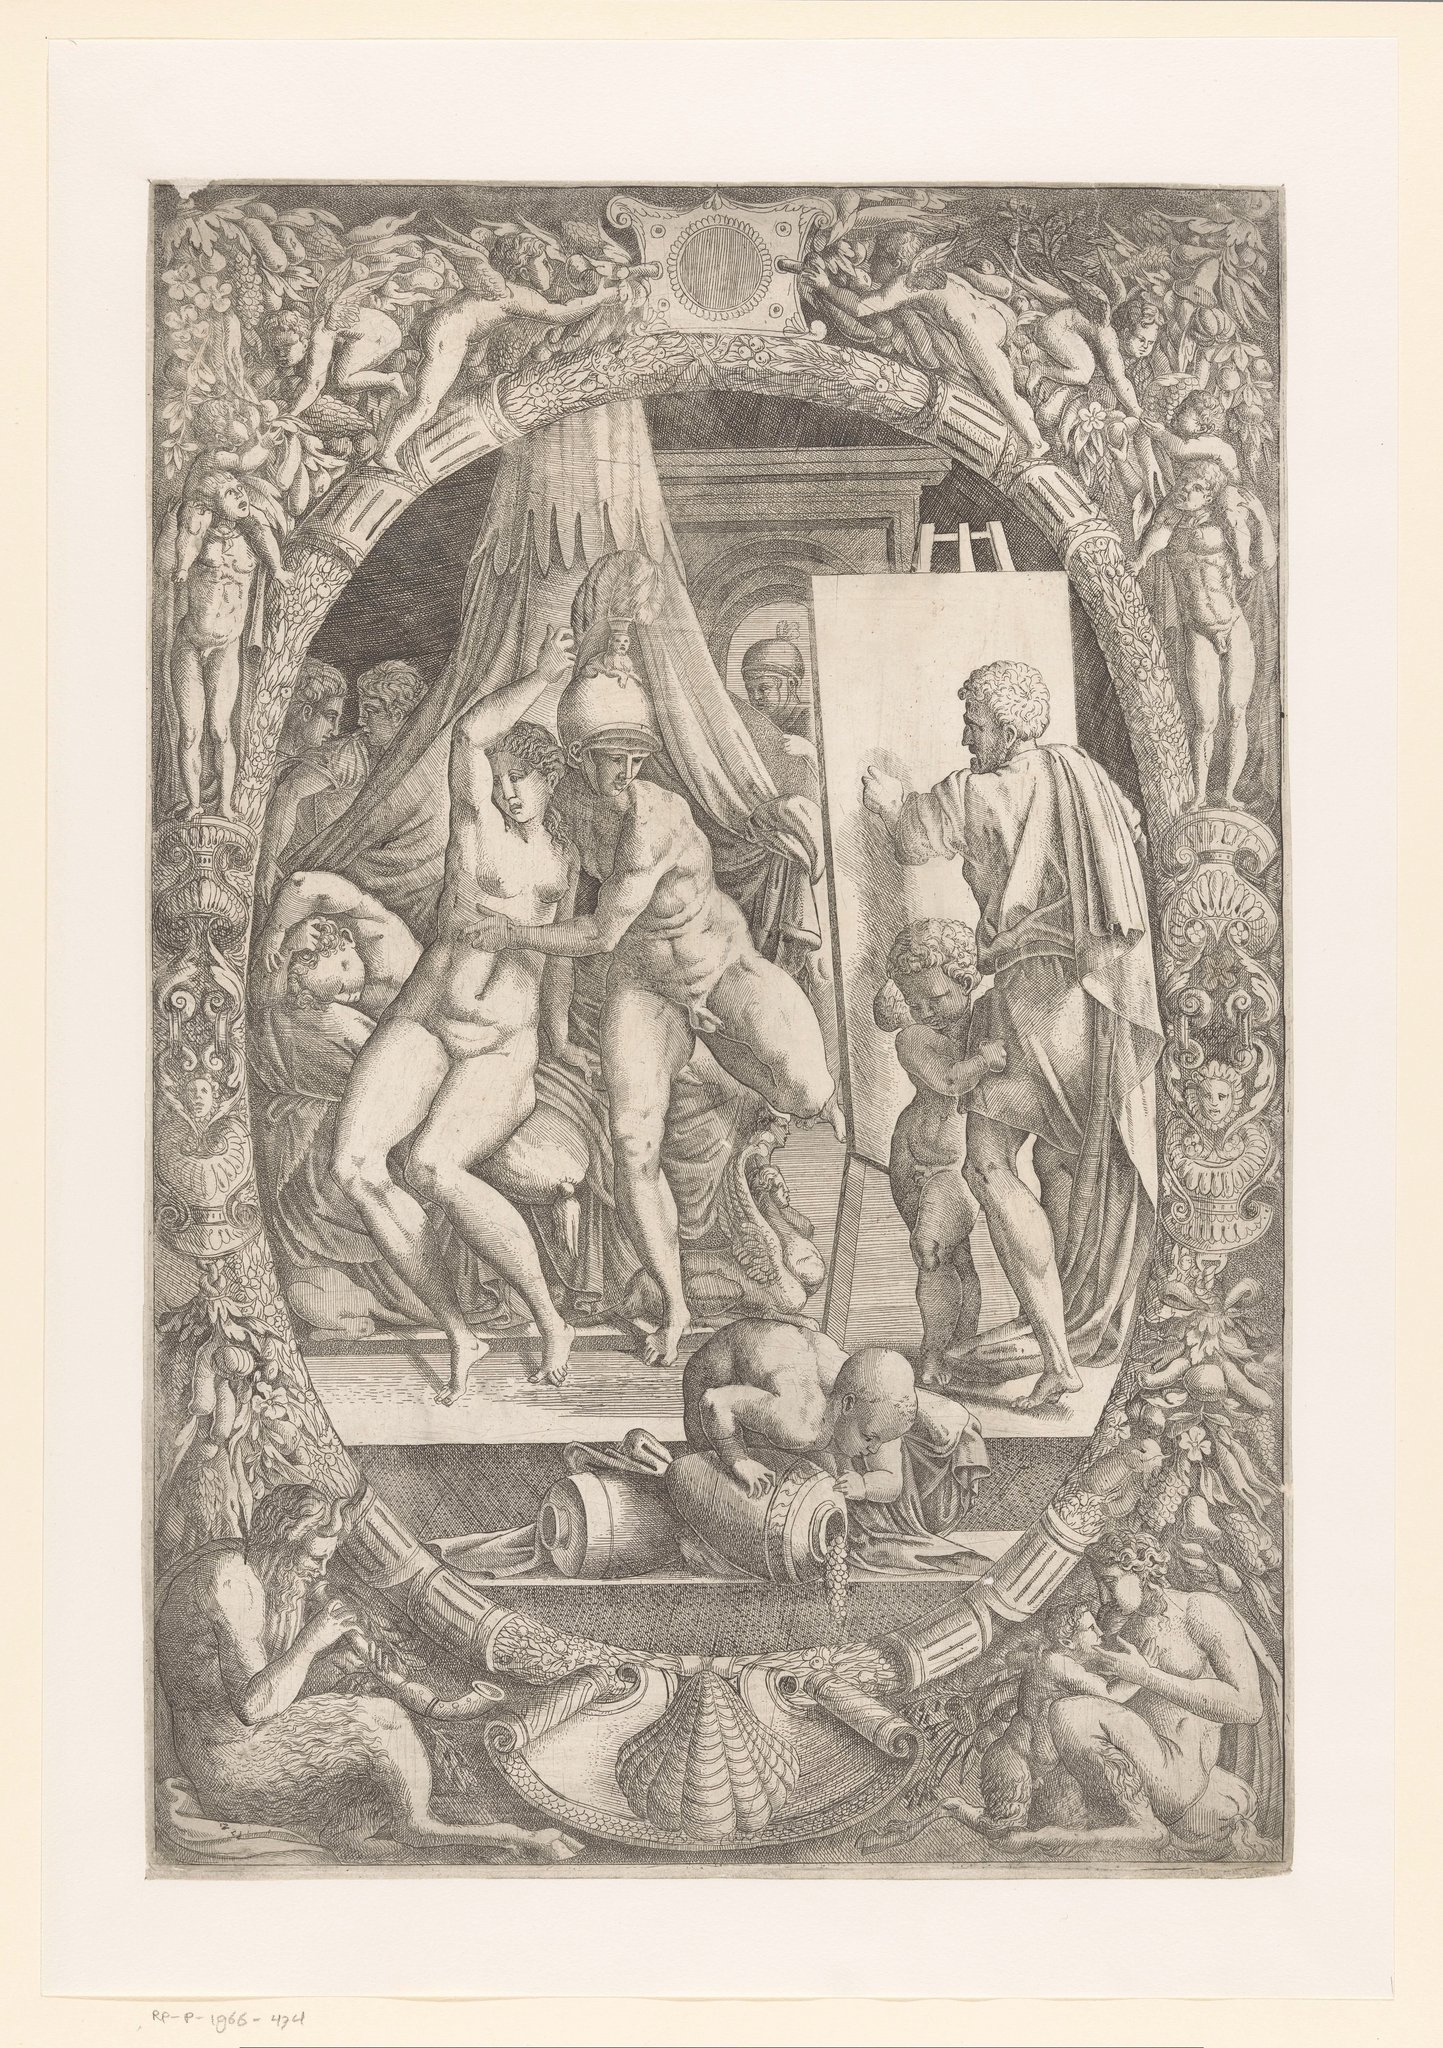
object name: print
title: Apelles schildert Alexander de Grote en Campaspe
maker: monogrammist iqv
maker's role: print maker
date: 1543-1545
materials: paper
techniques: etching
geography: fontainebleau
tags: satyr(s) (in general), apelles paints campaspe and falls in love with her; alexander yields her to him, cupids: 'amores', 'amoretti', 'putti'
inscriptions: collector's mark: Lugt 2228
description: Alexander de Grote en zijn geliefde Campaspe poseren voor de schilder Apelles, die achter zijn schildersezel staat. De voorstelling is gevat in een decoratieve ovale lijst met saters, putti en vruchten.